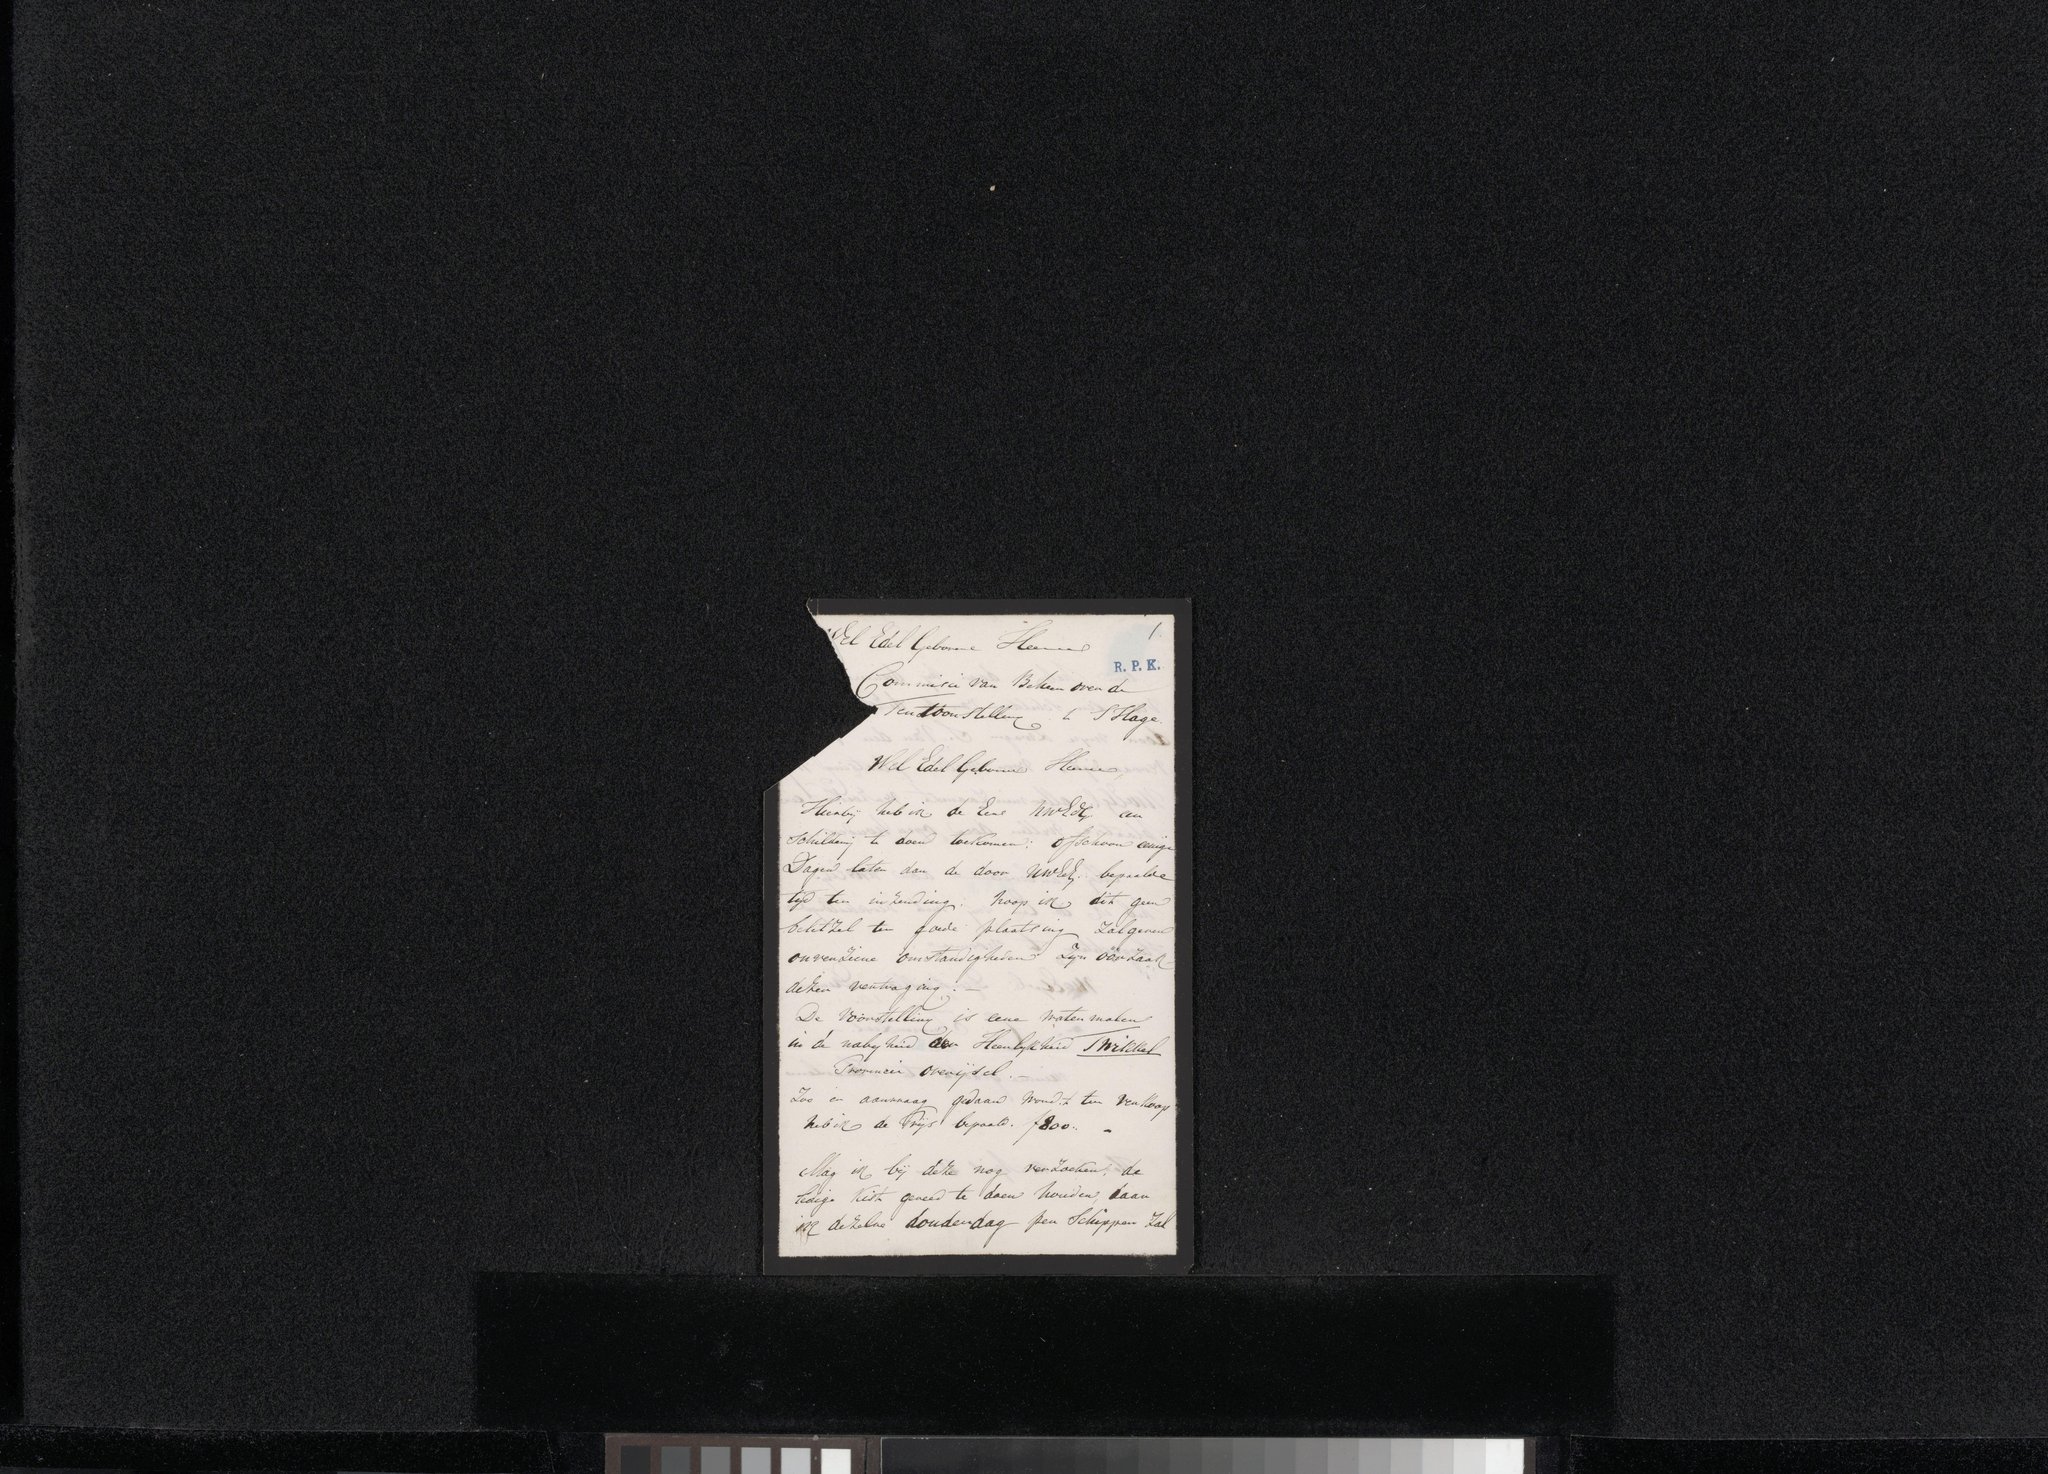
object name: letter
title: Brief aan de Commissie van de Tentoonstelling van Levende Meesters in Den Haag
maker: christiaan immerzeel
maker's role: print maker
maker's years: 1808-1886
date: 1843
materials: ink, paper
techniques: pen, writing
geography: haarlem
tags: overschie, arnhem, draughtsman, simon van den berg, painting (including book-illumination, miniature-painting), exhibition ~ art, money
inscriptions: collector's mark: Lugt 2233